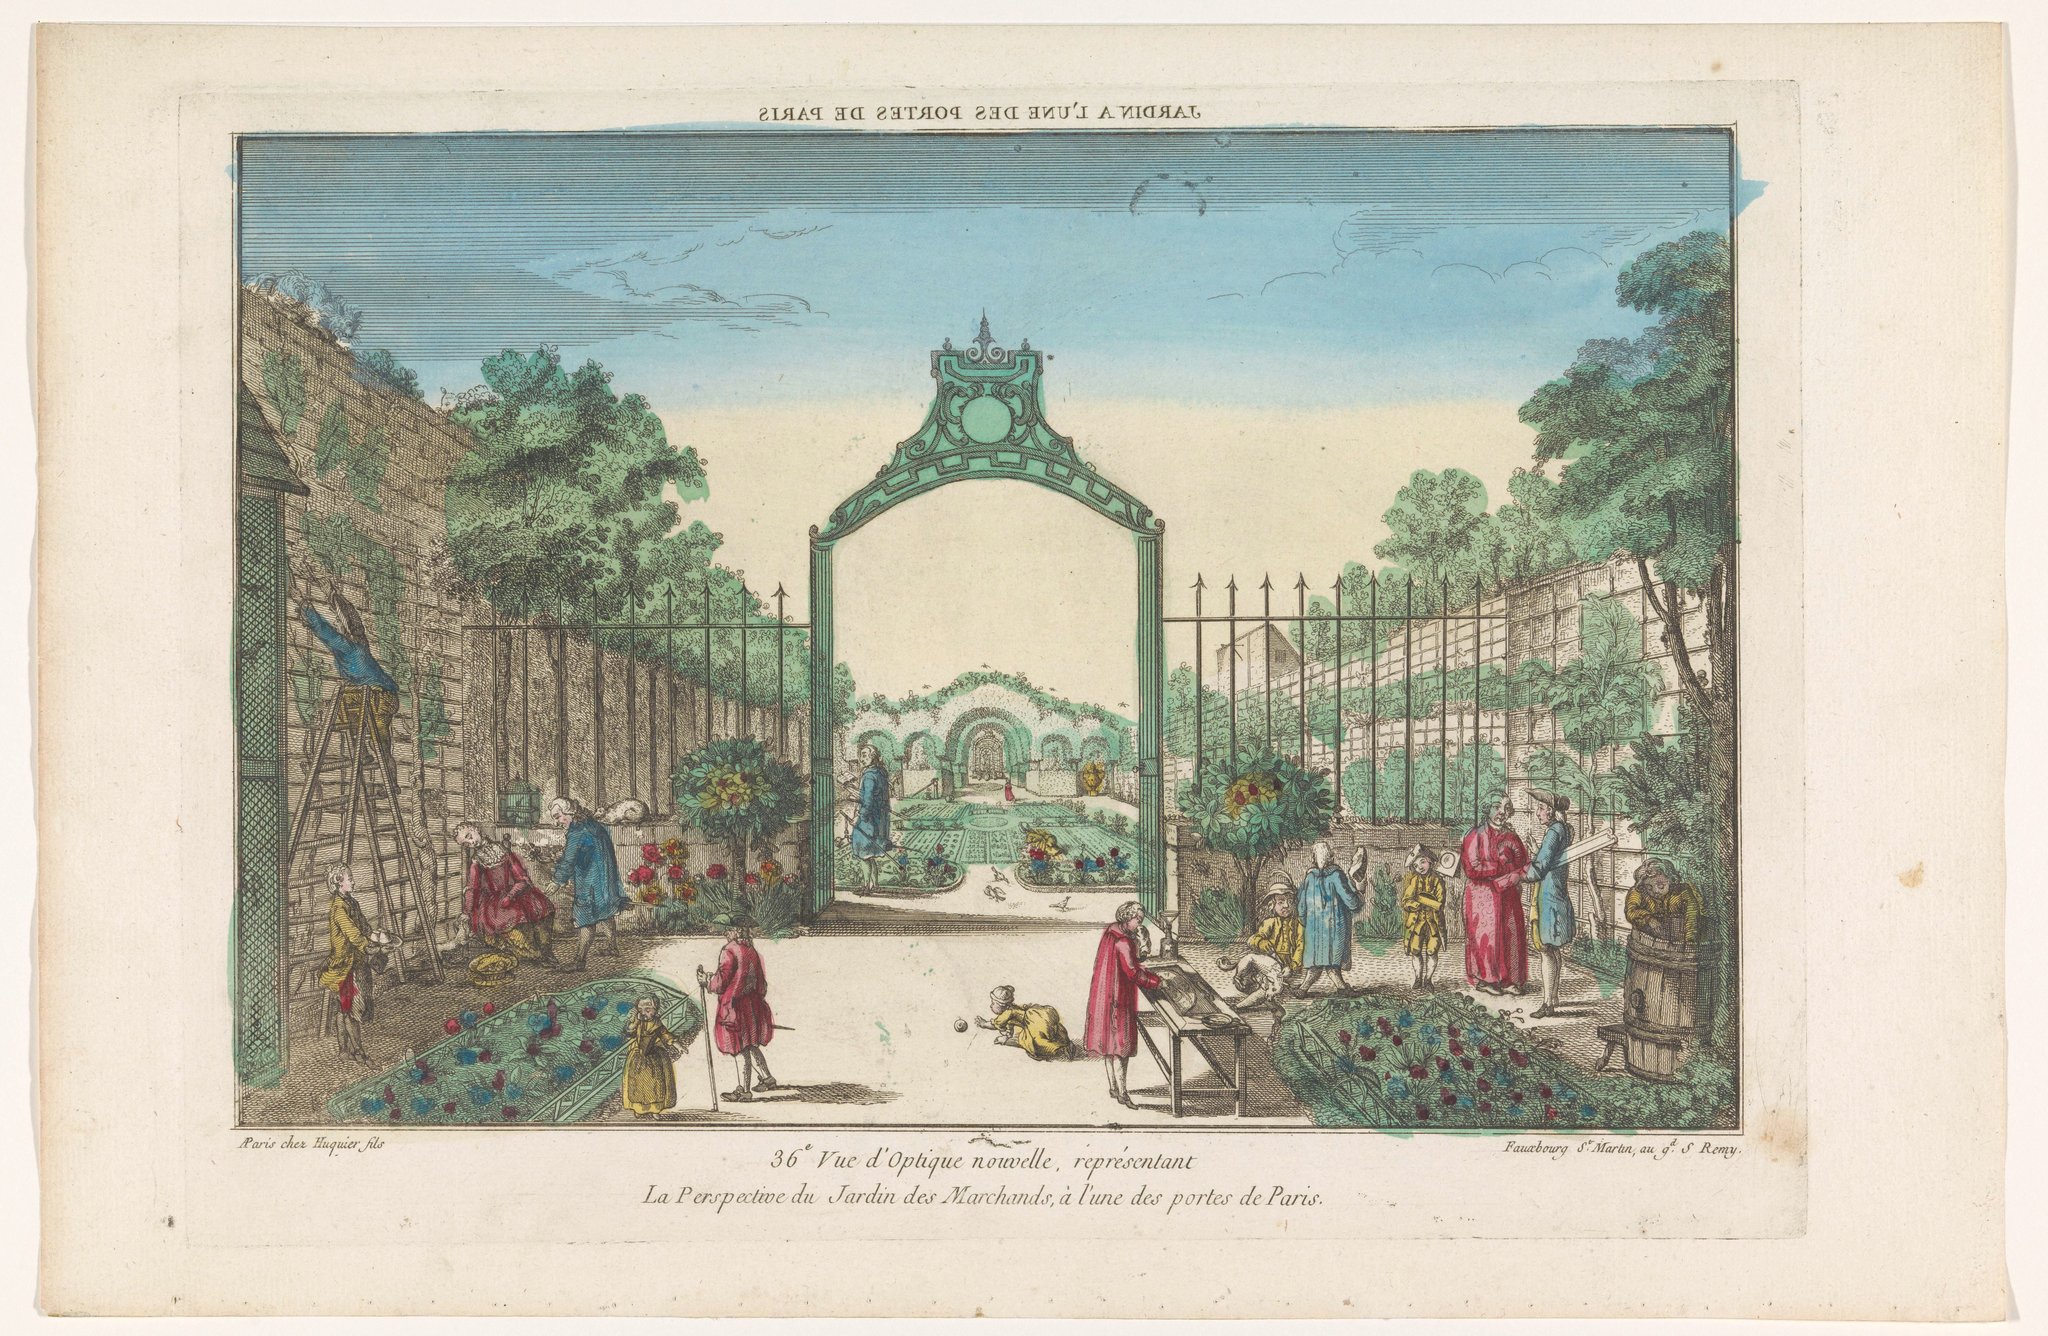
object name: print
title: Jardin a l'une des portes de Paris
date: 1735-1805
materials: paper, watercolor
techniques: brush, etching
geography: paris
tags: garden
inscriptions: watermark, collector's mark: Lugt 2166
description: In de tuin zijn verschillende figuren, waaronder een kind met een bal, een man met een boek, een man die de haren van een dier knipt en een man op een ladder. Genummerd: 35.